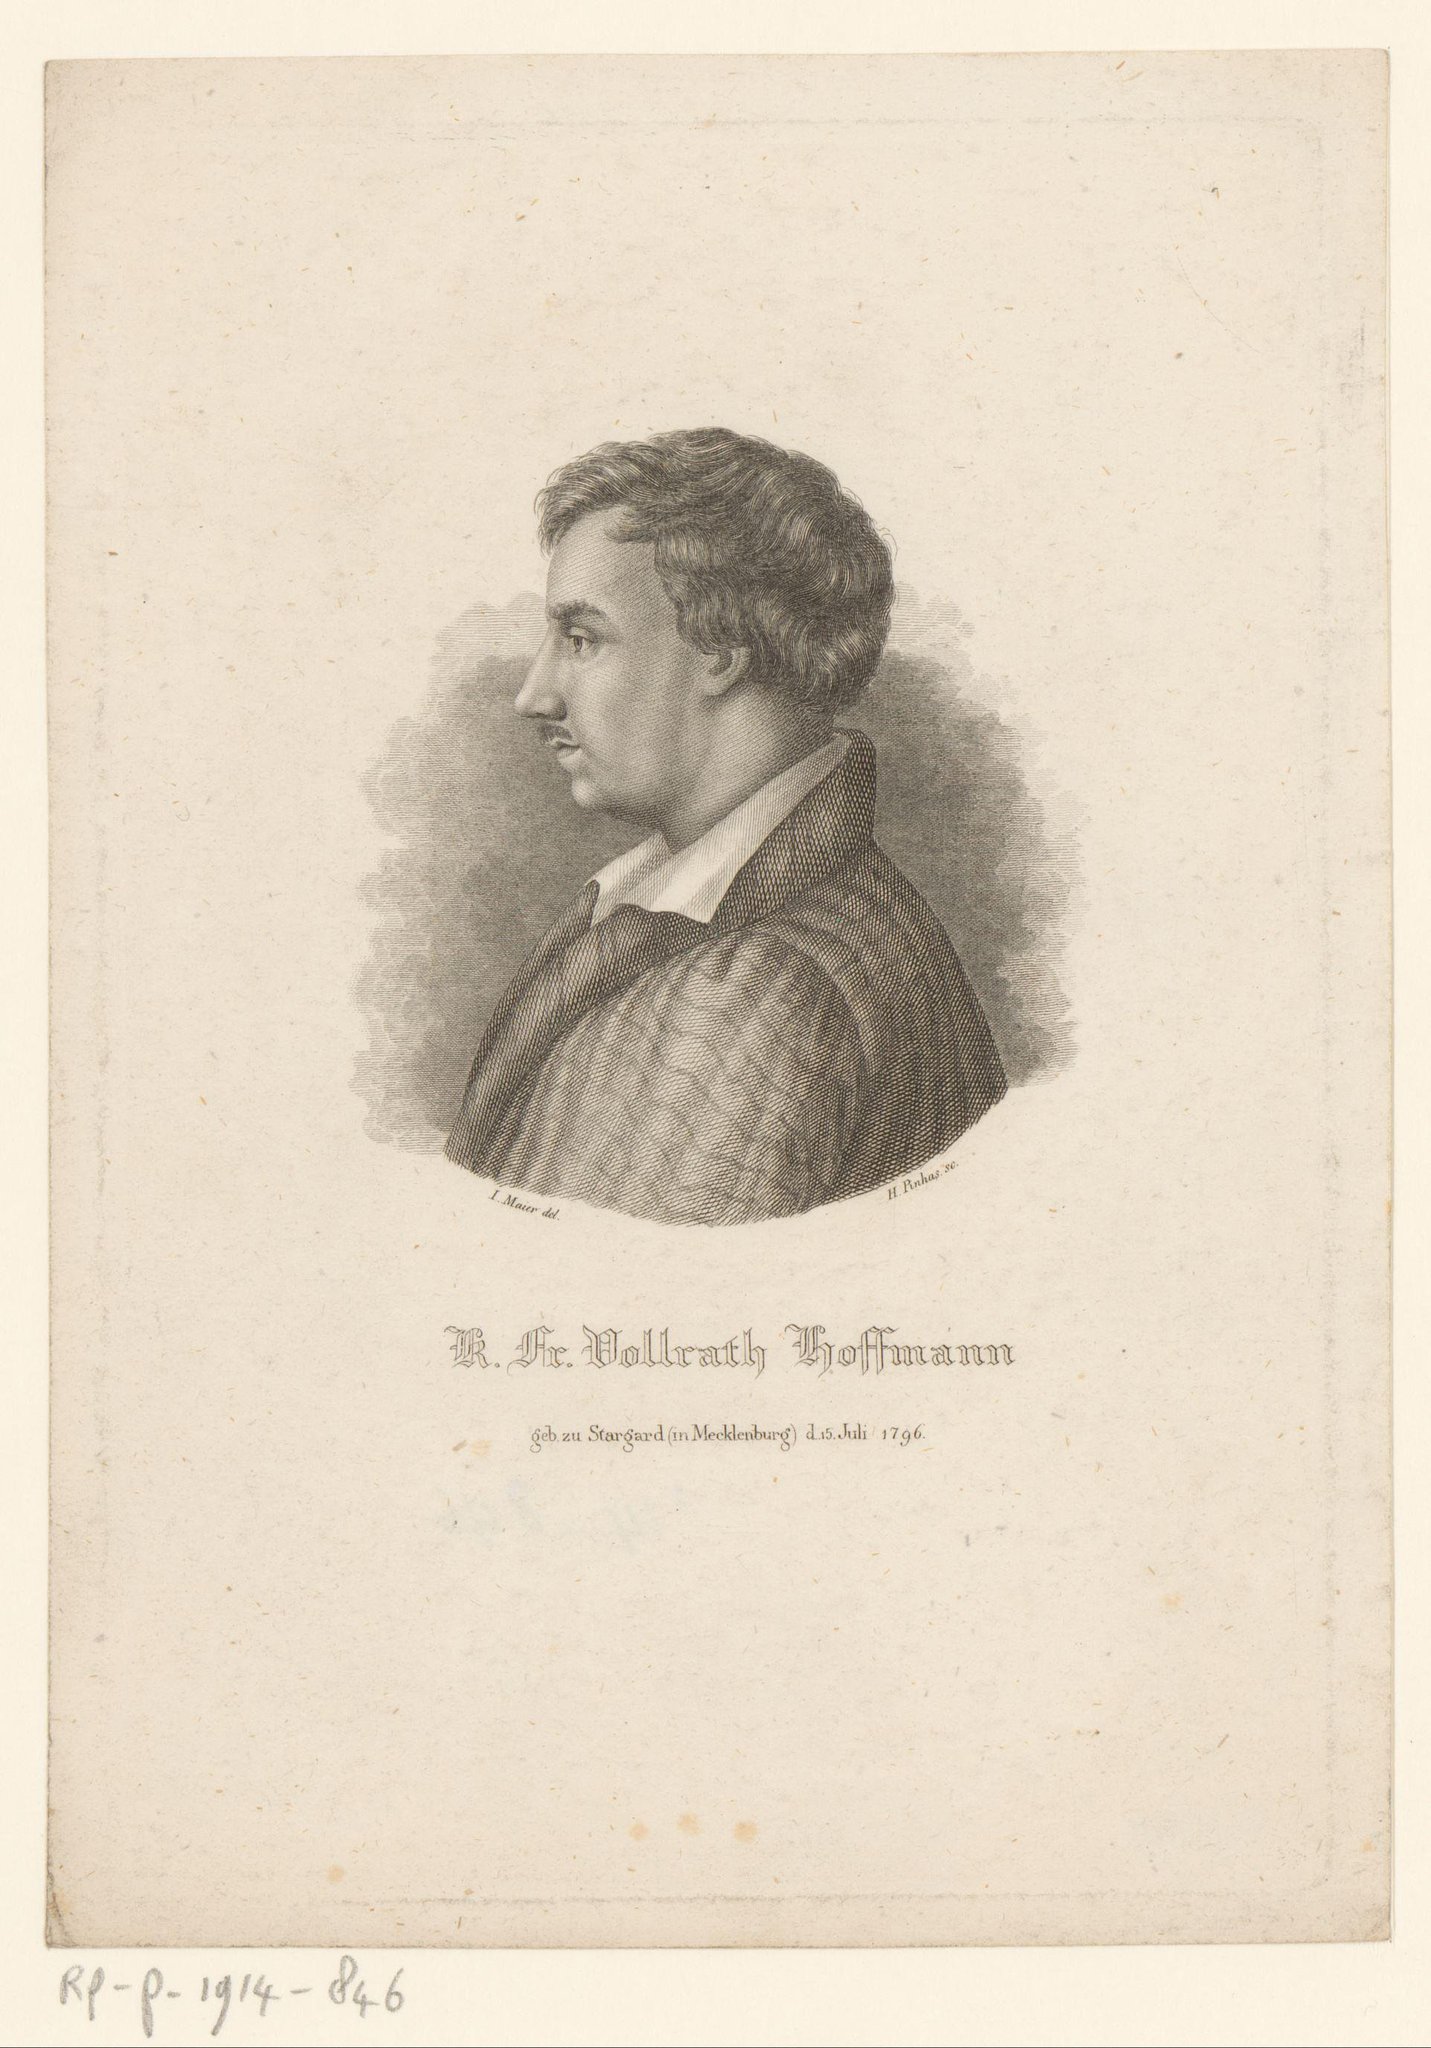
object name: print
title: Portret van Karl Friedrich Vollrath Hoffmann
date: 1811-1844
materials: paper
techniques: engraving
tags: historical persons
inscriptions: collector's mark: Lugt 2228